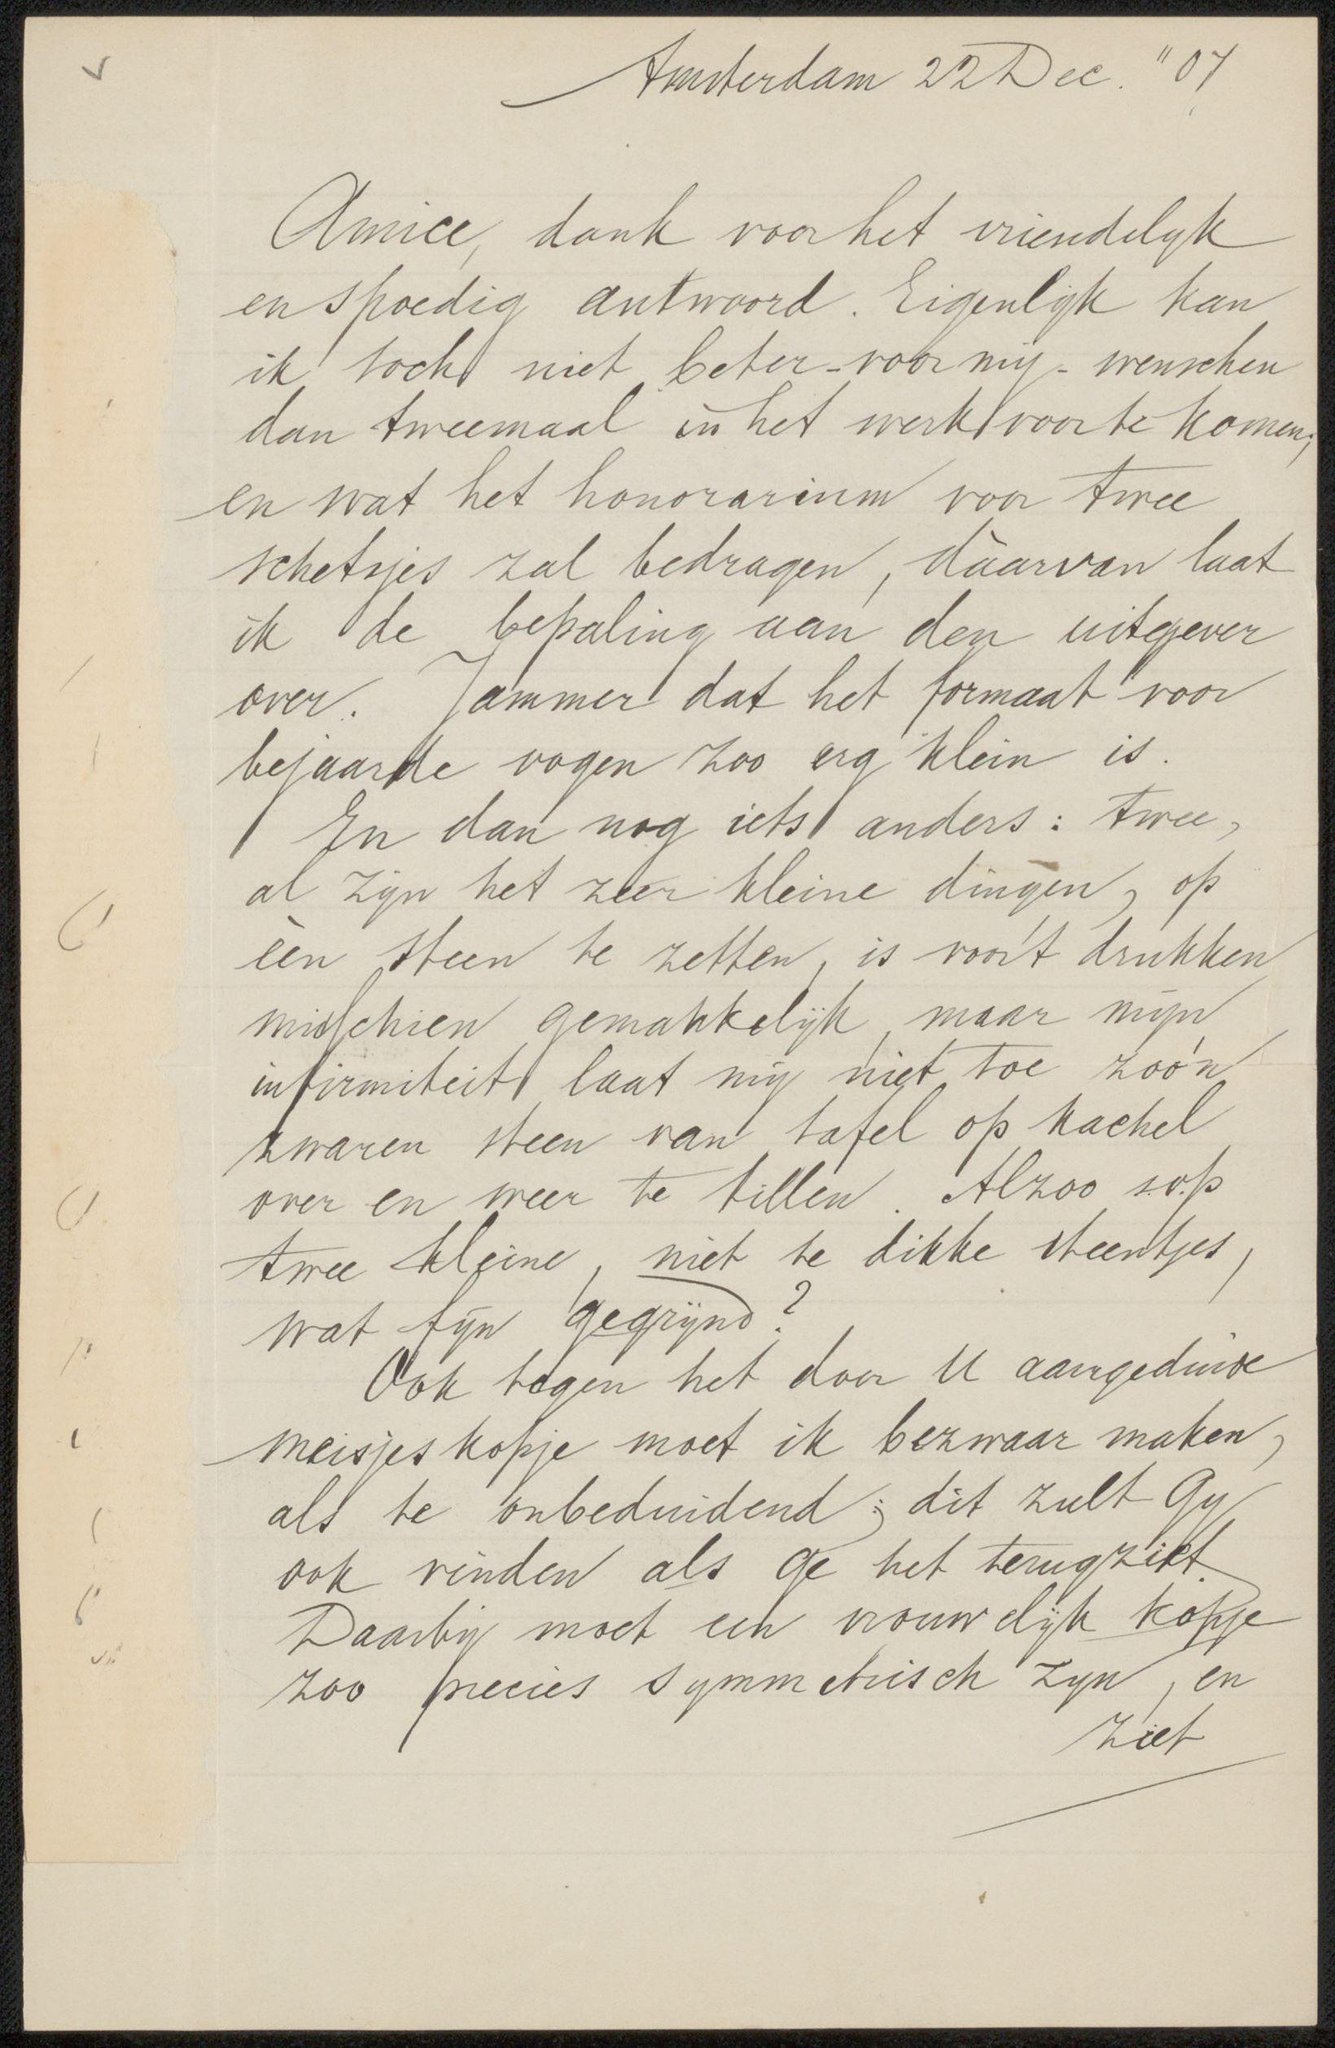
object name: letter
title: Brief aan Jan Veth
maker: august allebé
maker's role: draughtsman, print maker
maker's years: 1838-1927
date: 1907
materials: ink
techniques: pen, writing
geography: amsterdam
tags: dordrecht, painter, print maker, draughtsman, designer, jan veth, the graphic arts, money, printed matter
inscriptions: collector's mark: ‘RPK’